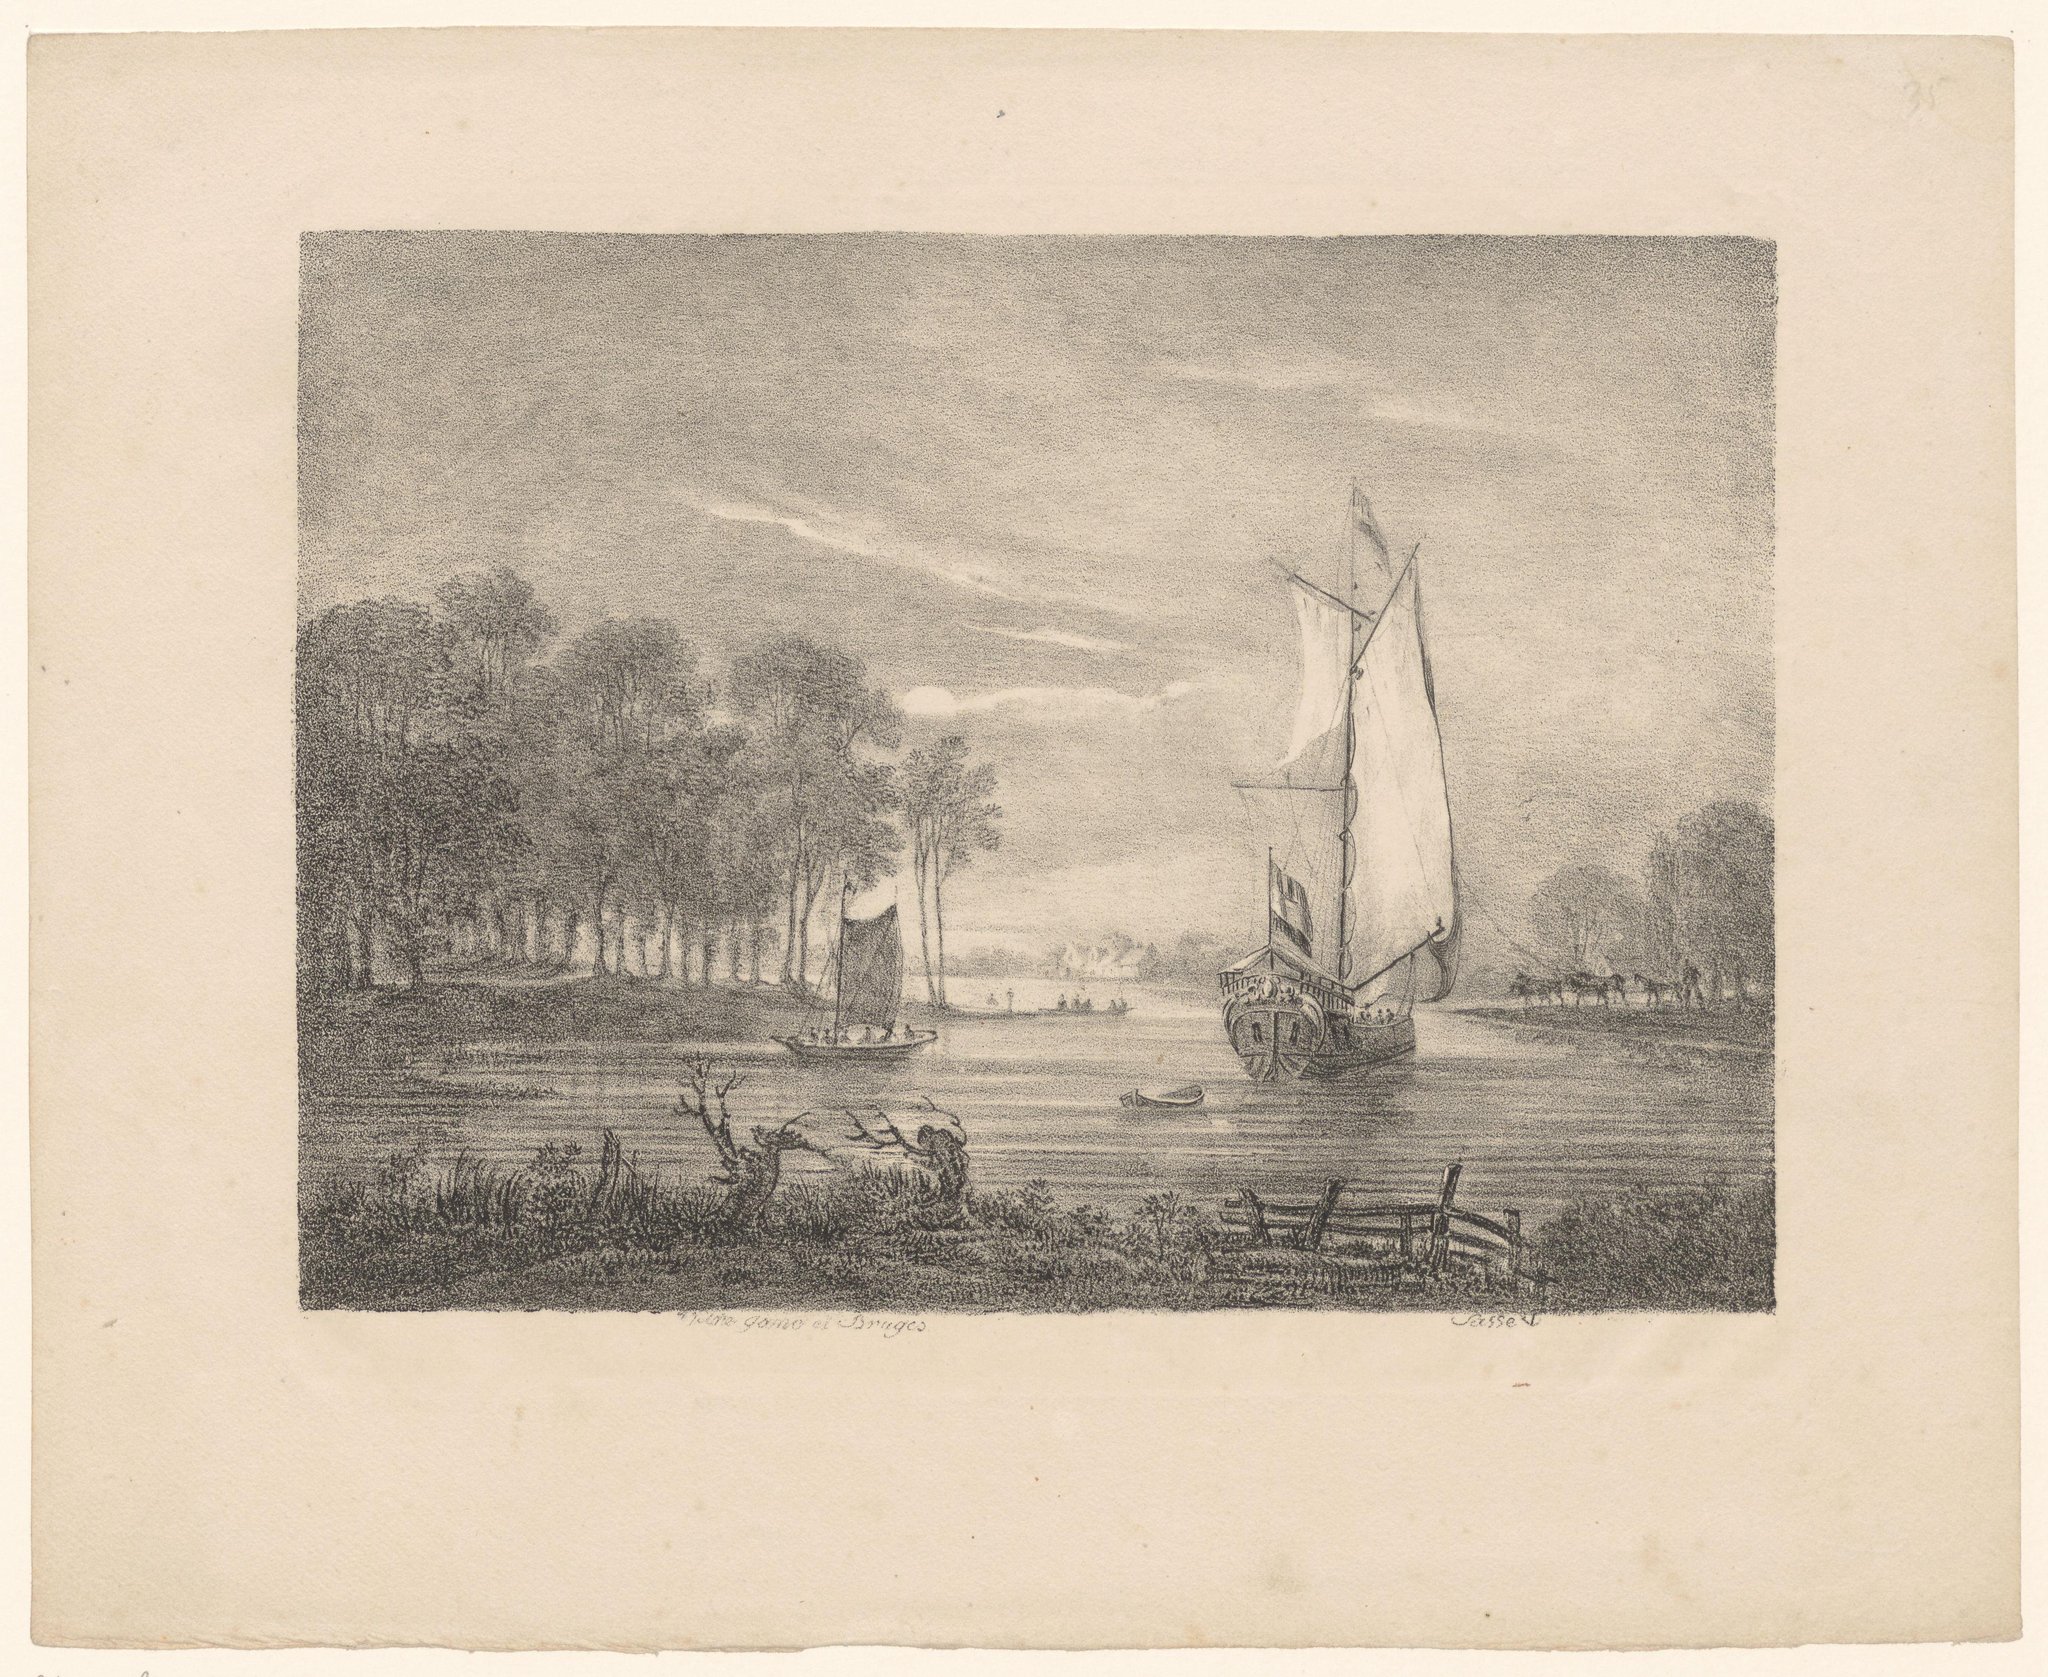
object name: print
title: Entre Gand et Bruges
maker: richard sasse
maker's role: print maker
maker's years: 1774-1849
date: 1800-1849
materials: paper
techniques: lithograph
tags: river, landscapes in the temperate zone (+ landscape with figures, staffage), boat propelled by man or animal, ghent, bruges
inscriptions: collector's mark: Lugt 2228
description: Prent behoort mogelijk tot de serie 'L'art de dessiner le paysage d'apres nature'. Deze serie is in tien delen met elk zes lithografieën uitgegeven.